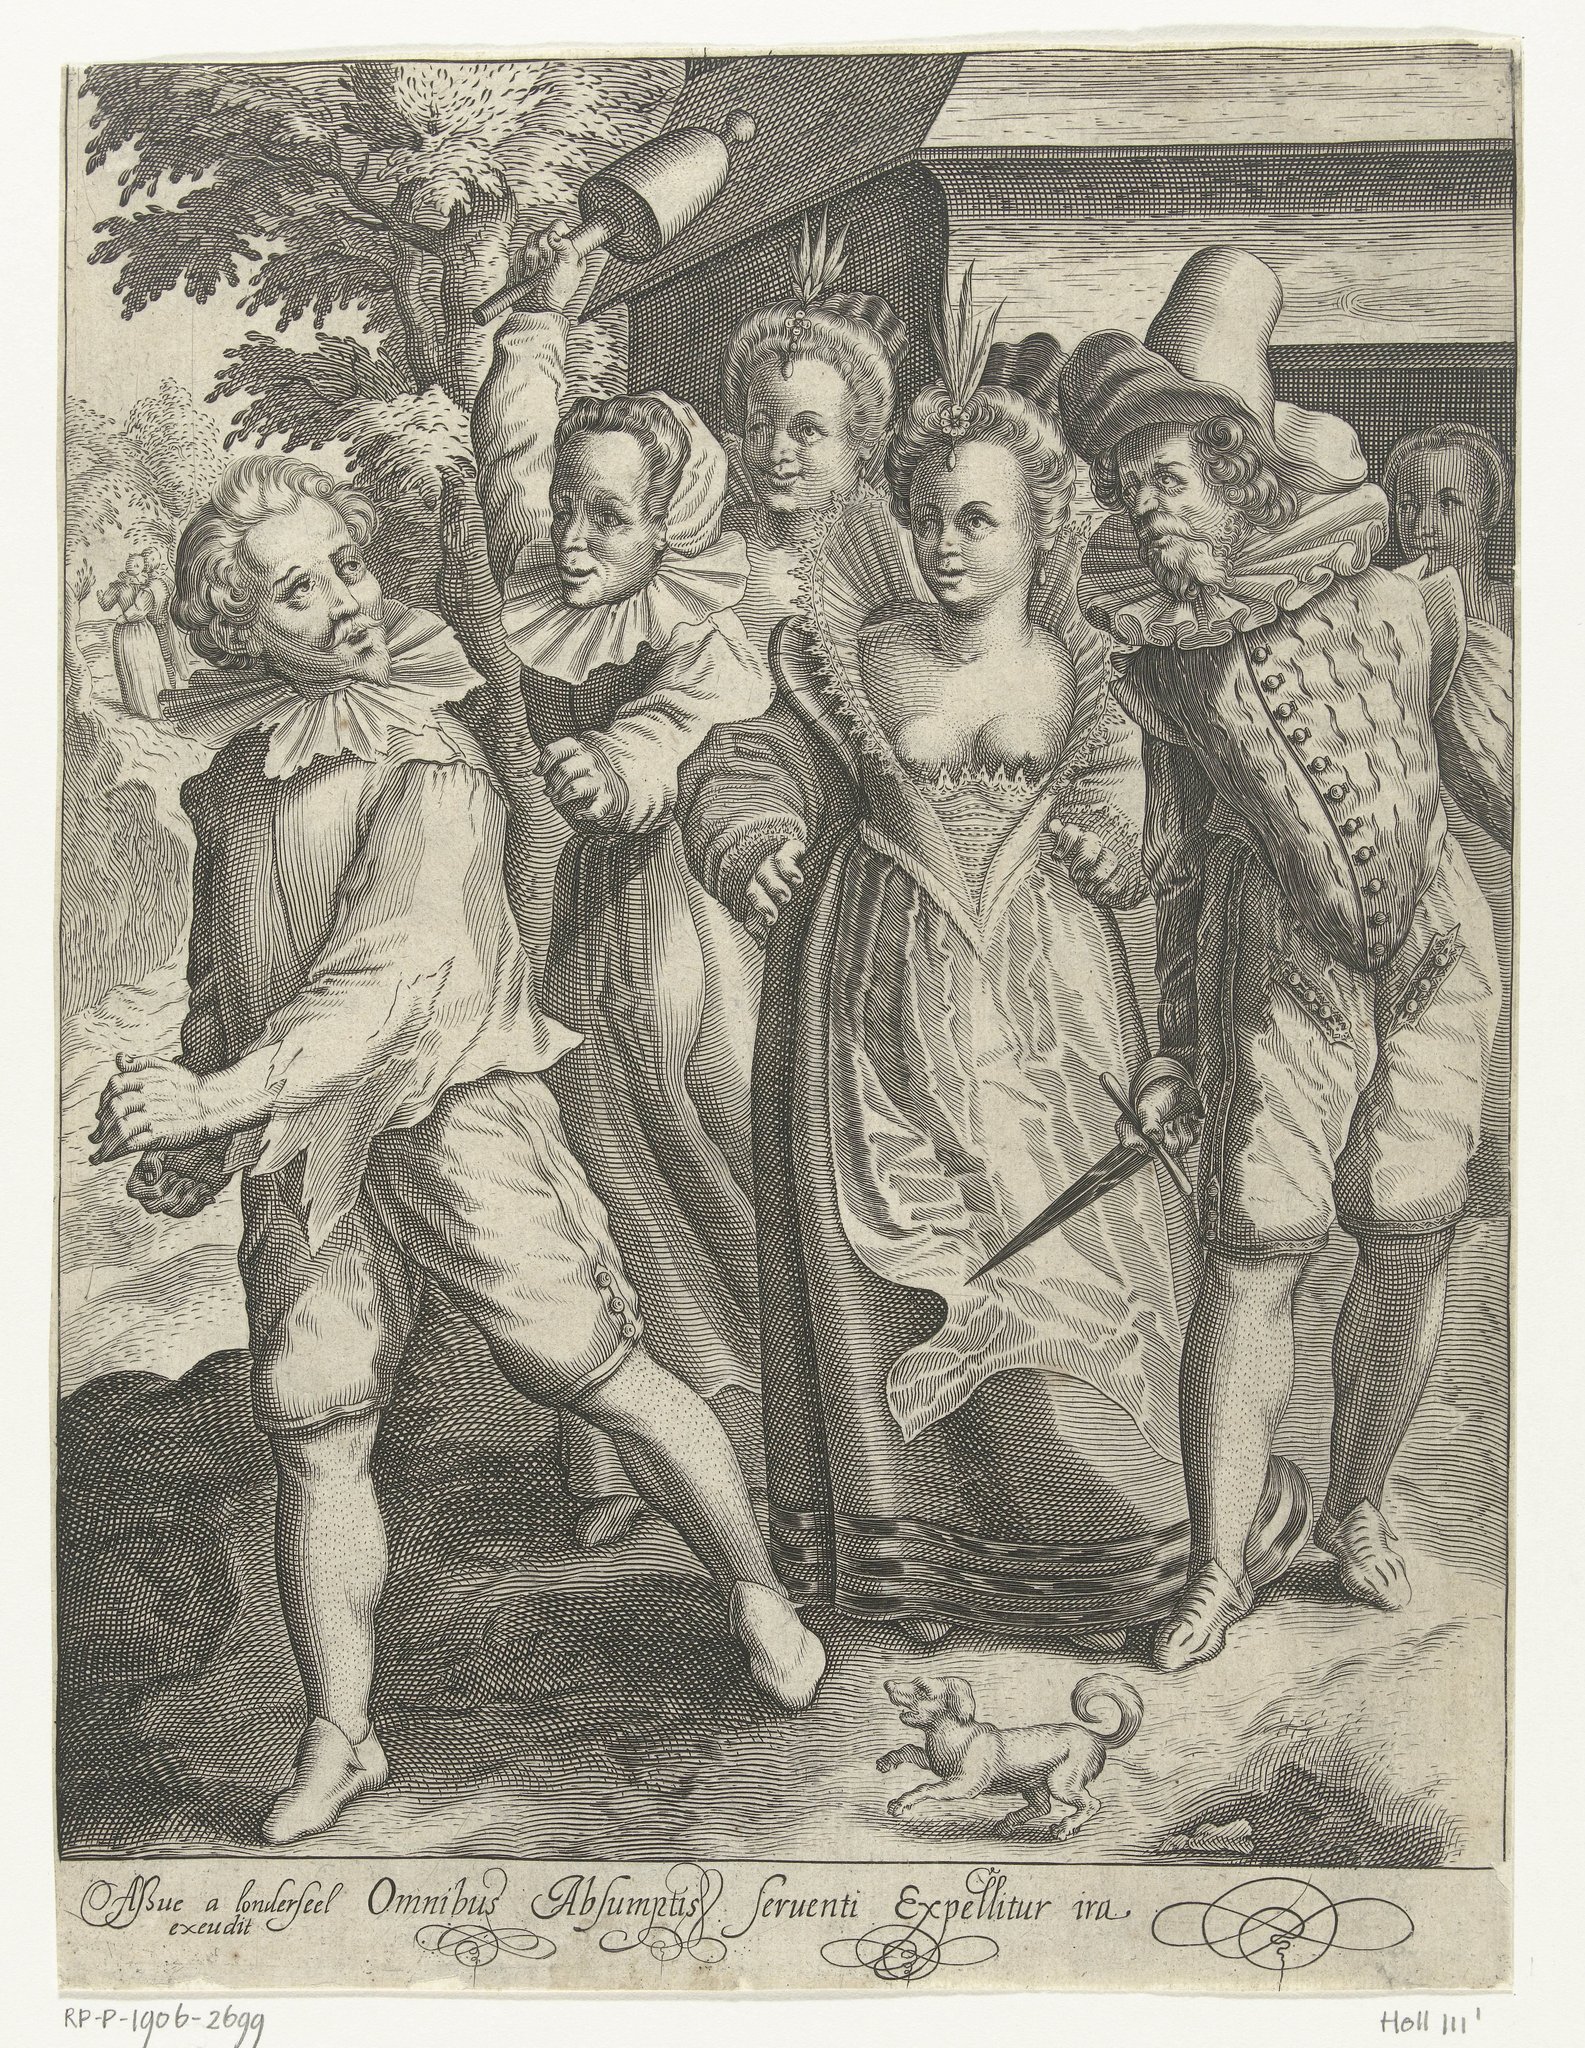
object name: print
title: De verloren zoon heeft zijn geld verspild en wordt weggejaagd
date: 1581-1656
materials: paper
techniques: engraving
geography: netherlands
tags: when all his money is squandered the prodigal son is chased away by the harlots, driving off the robbed man (brothel scene)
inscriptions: collector's mark: Lugt 2228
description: De verloren zoon heeft zijn geld verspild en wordt weggejaagd door het gezelschap van hoeren waar hij zich mee heeft vermaakt.